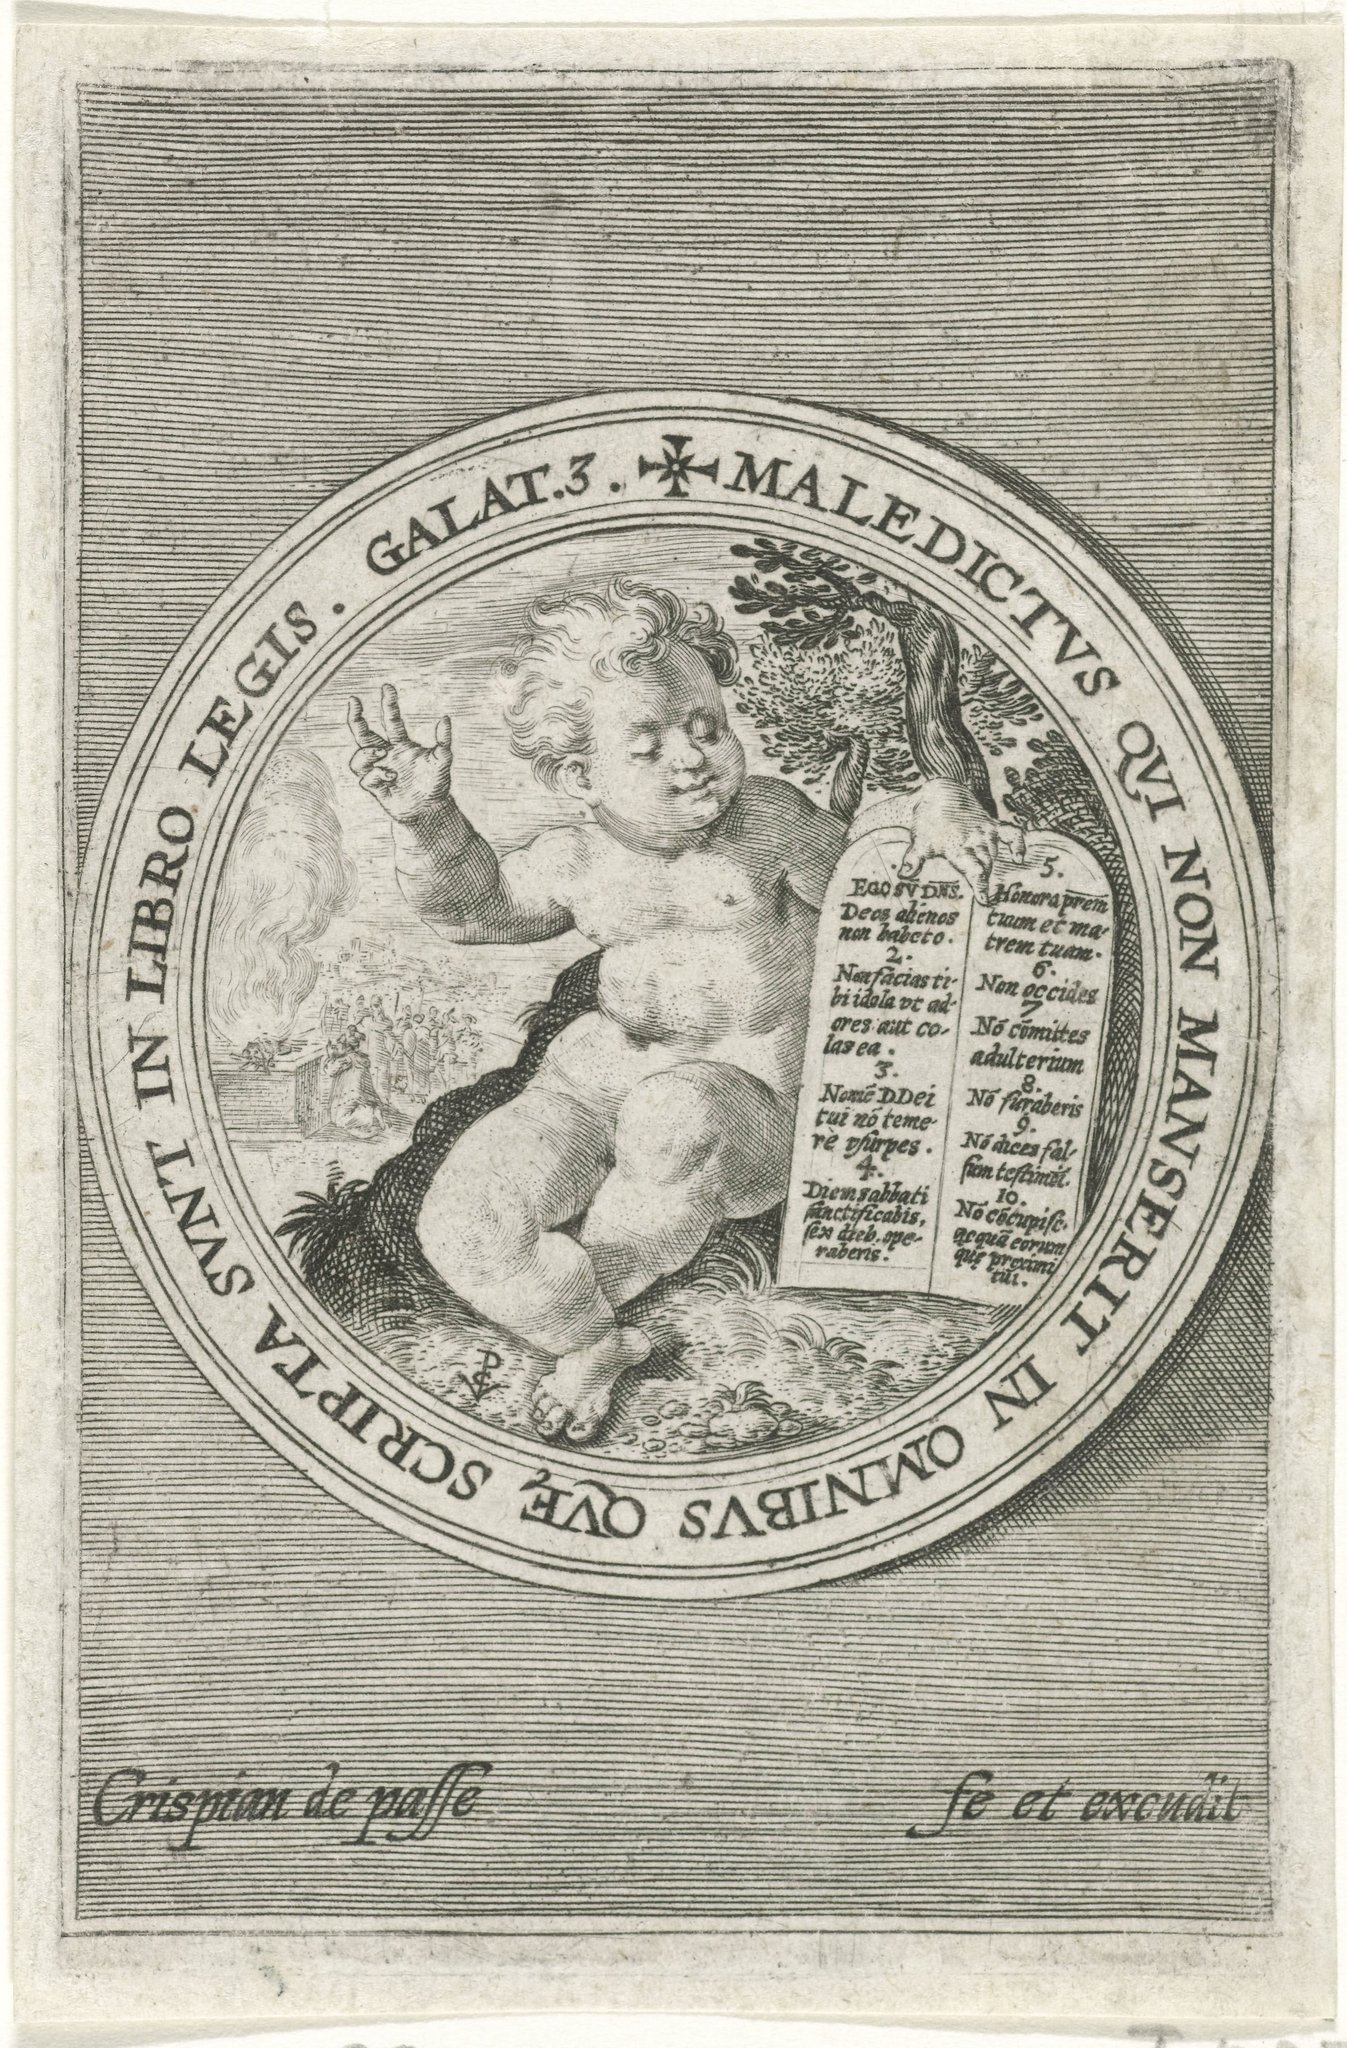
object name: print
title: Putti die Gods woord verbeelden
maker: crispijn van de passe (i)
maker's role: draughtsman, print maker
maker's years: 1564-1637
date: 1594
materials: paper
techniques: engraving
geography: cologne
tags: sacrificing a burnt offering ~ jewish religion, angel(s) represented as child(ren), the new tables of the law (exodus 34)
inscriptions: collector's mark: Lugt 2228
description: Medaillon met een putto die op de tafelen der wet leunt en een zegenend gebaar maakt. Op de achtergrond een altaar met een brandoffer. De prent heeft een omlijsting met een Bijbelcitaat uit Gal. 3 in het Latijn.